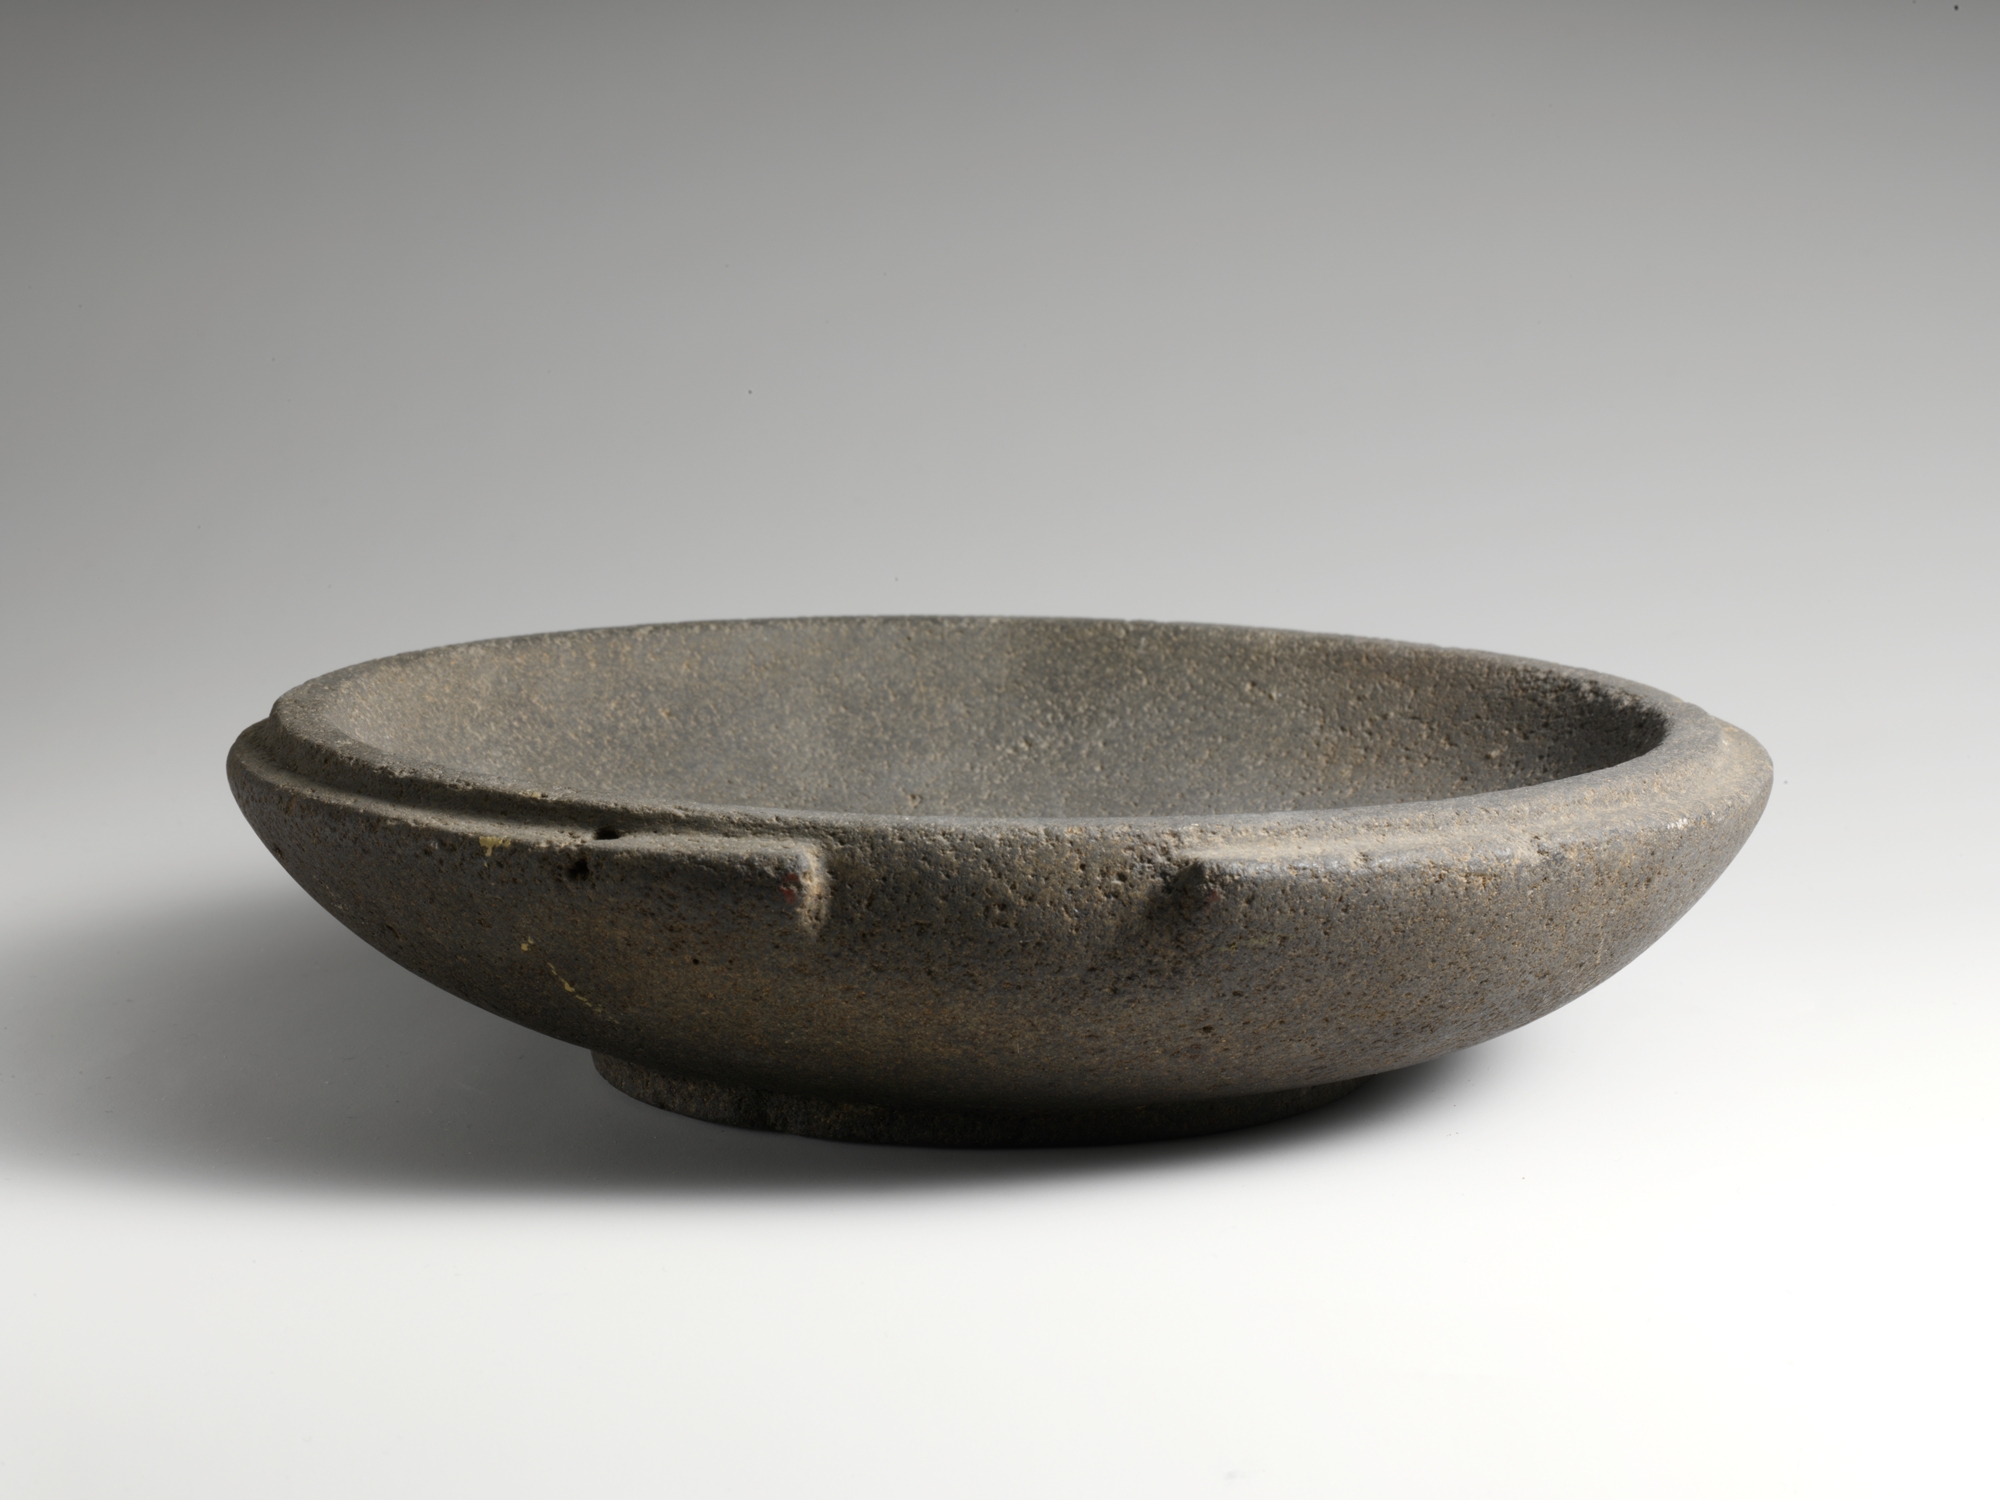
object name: shallow bowl or palette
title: Basalt mortar or plate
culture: cypriot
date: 1600-1050 BCE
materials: stone